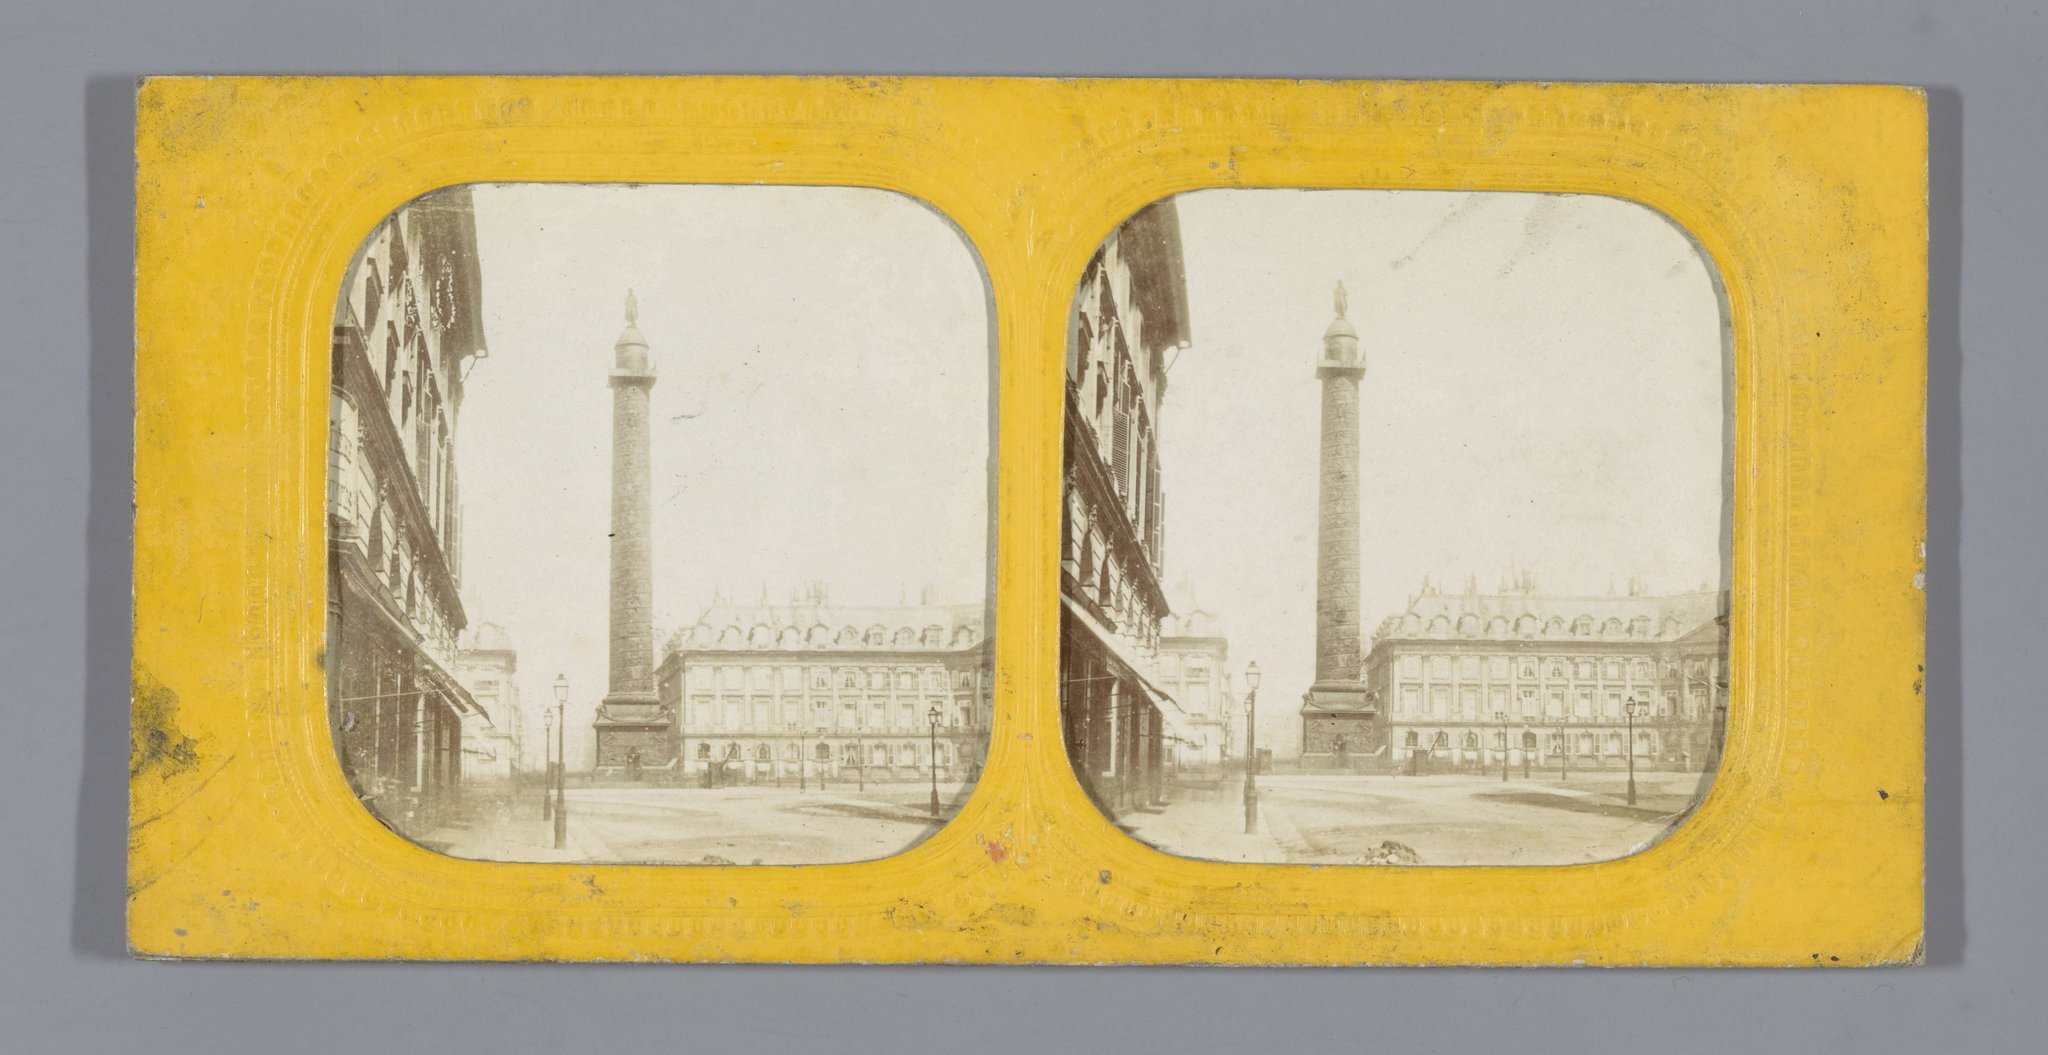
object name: tissue stereograph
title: Colonne Vendome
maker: Anonymous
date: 1855-1875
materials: cardboard, paper, photographic support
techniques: albumen print, hand coloring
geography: paris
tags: square, place, circus, etc., obelisk, needle